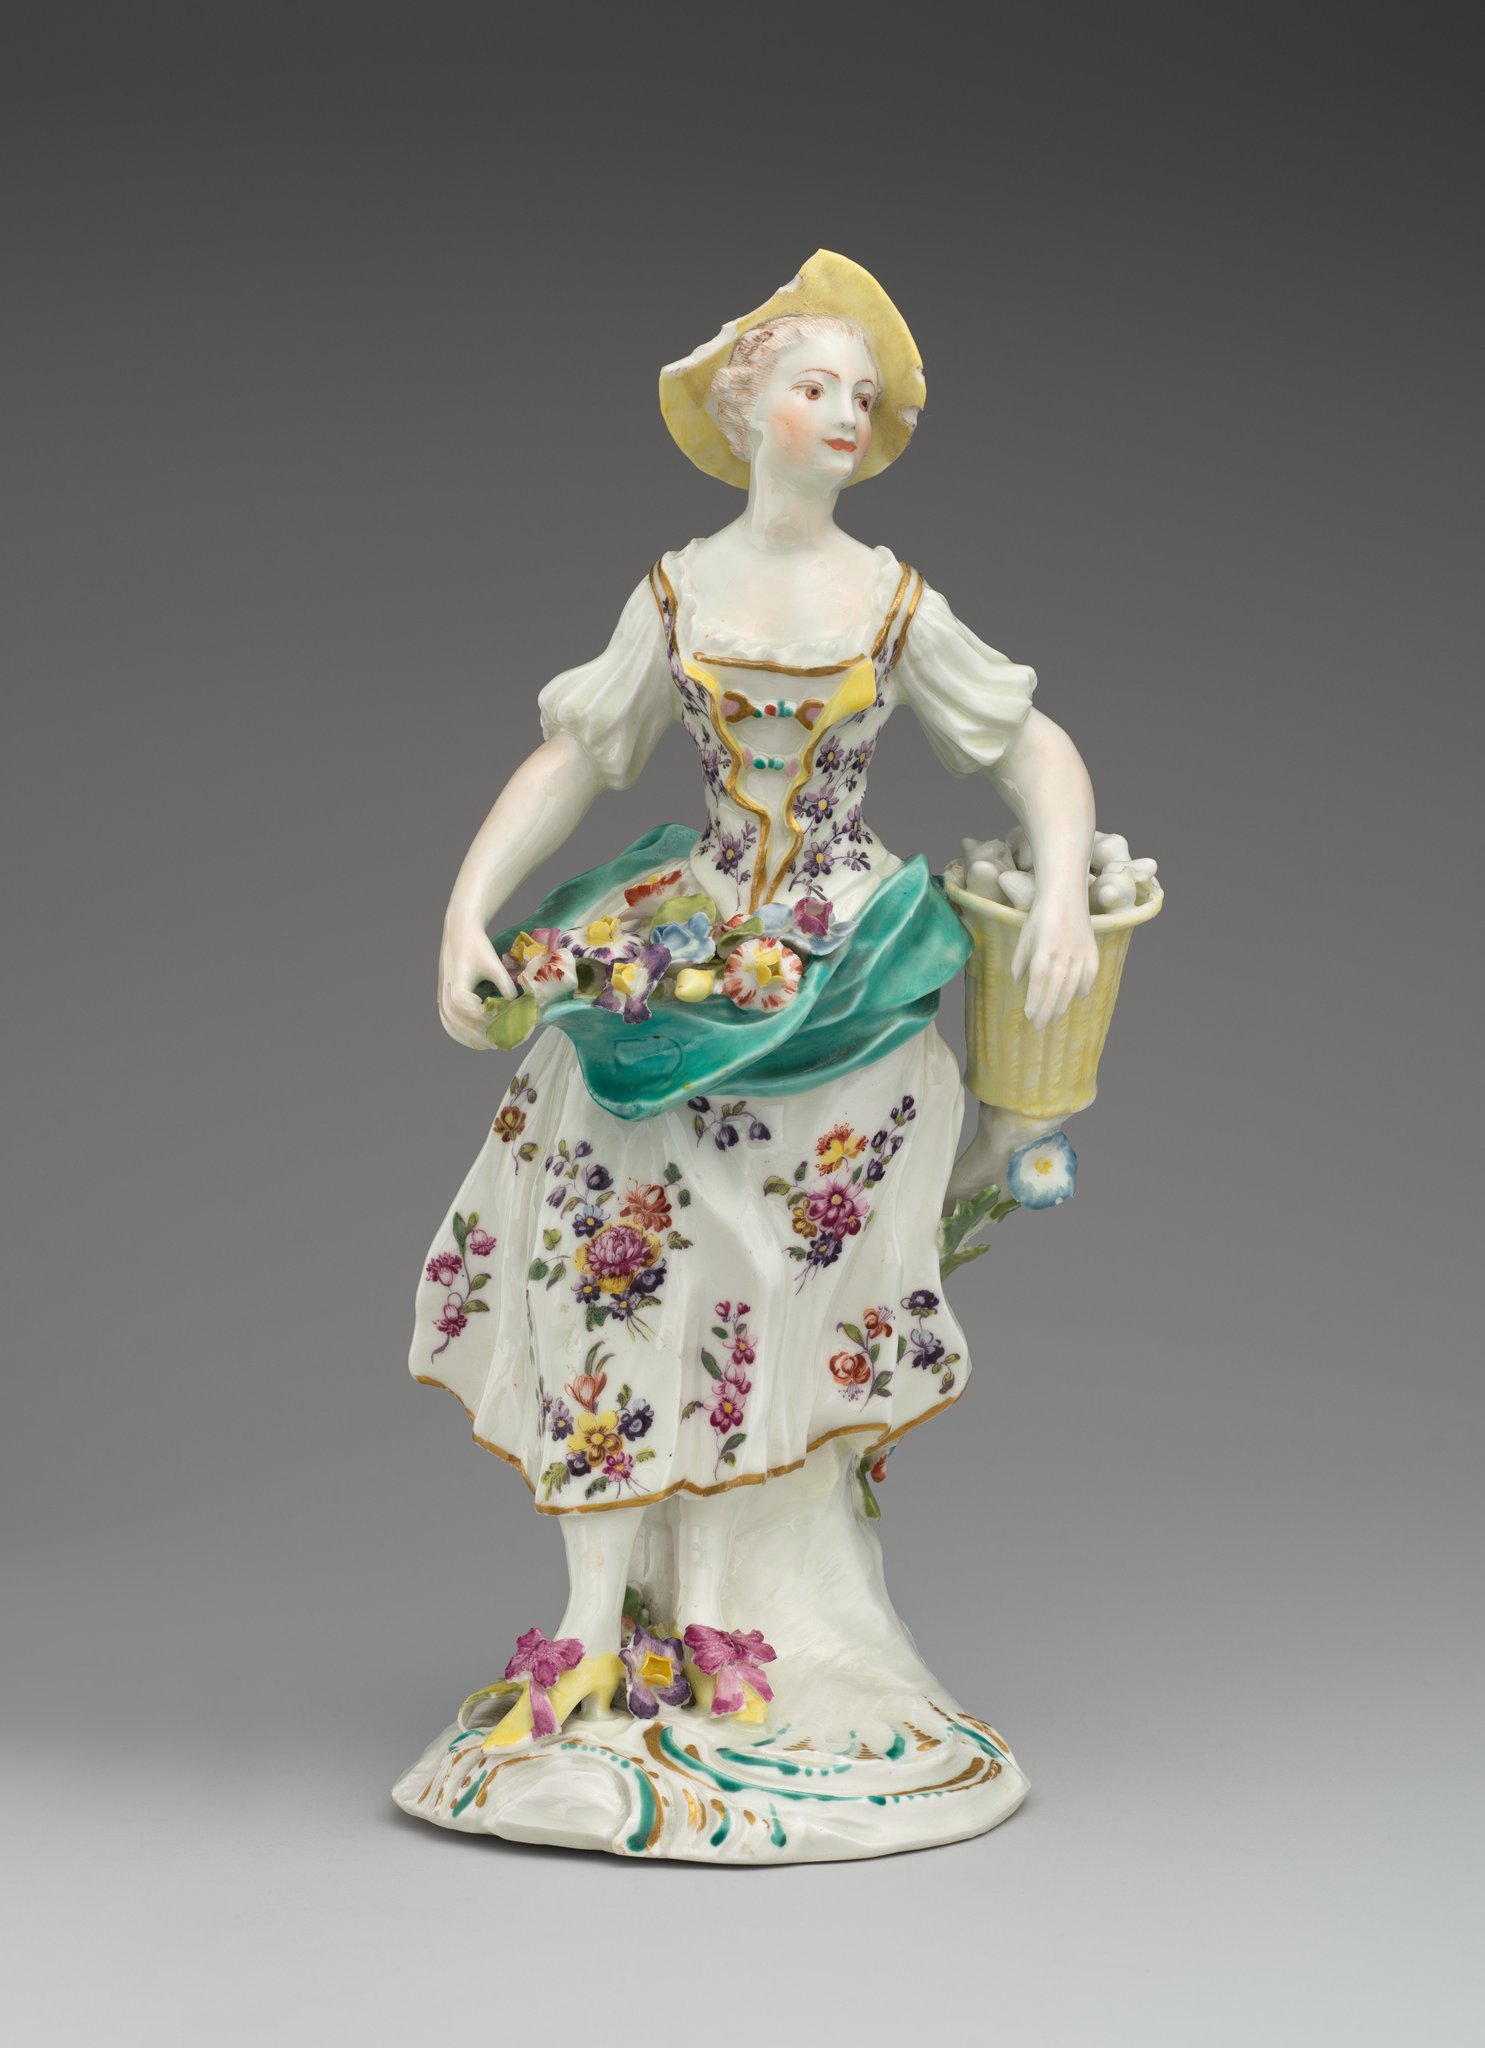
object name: figure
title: Female gardener (one of a pair)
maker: derby porcelain manufactory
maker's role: factory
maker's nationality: british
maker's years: 1751-1785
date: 1760-1765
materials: soft paste porcelain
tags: women,gardeners